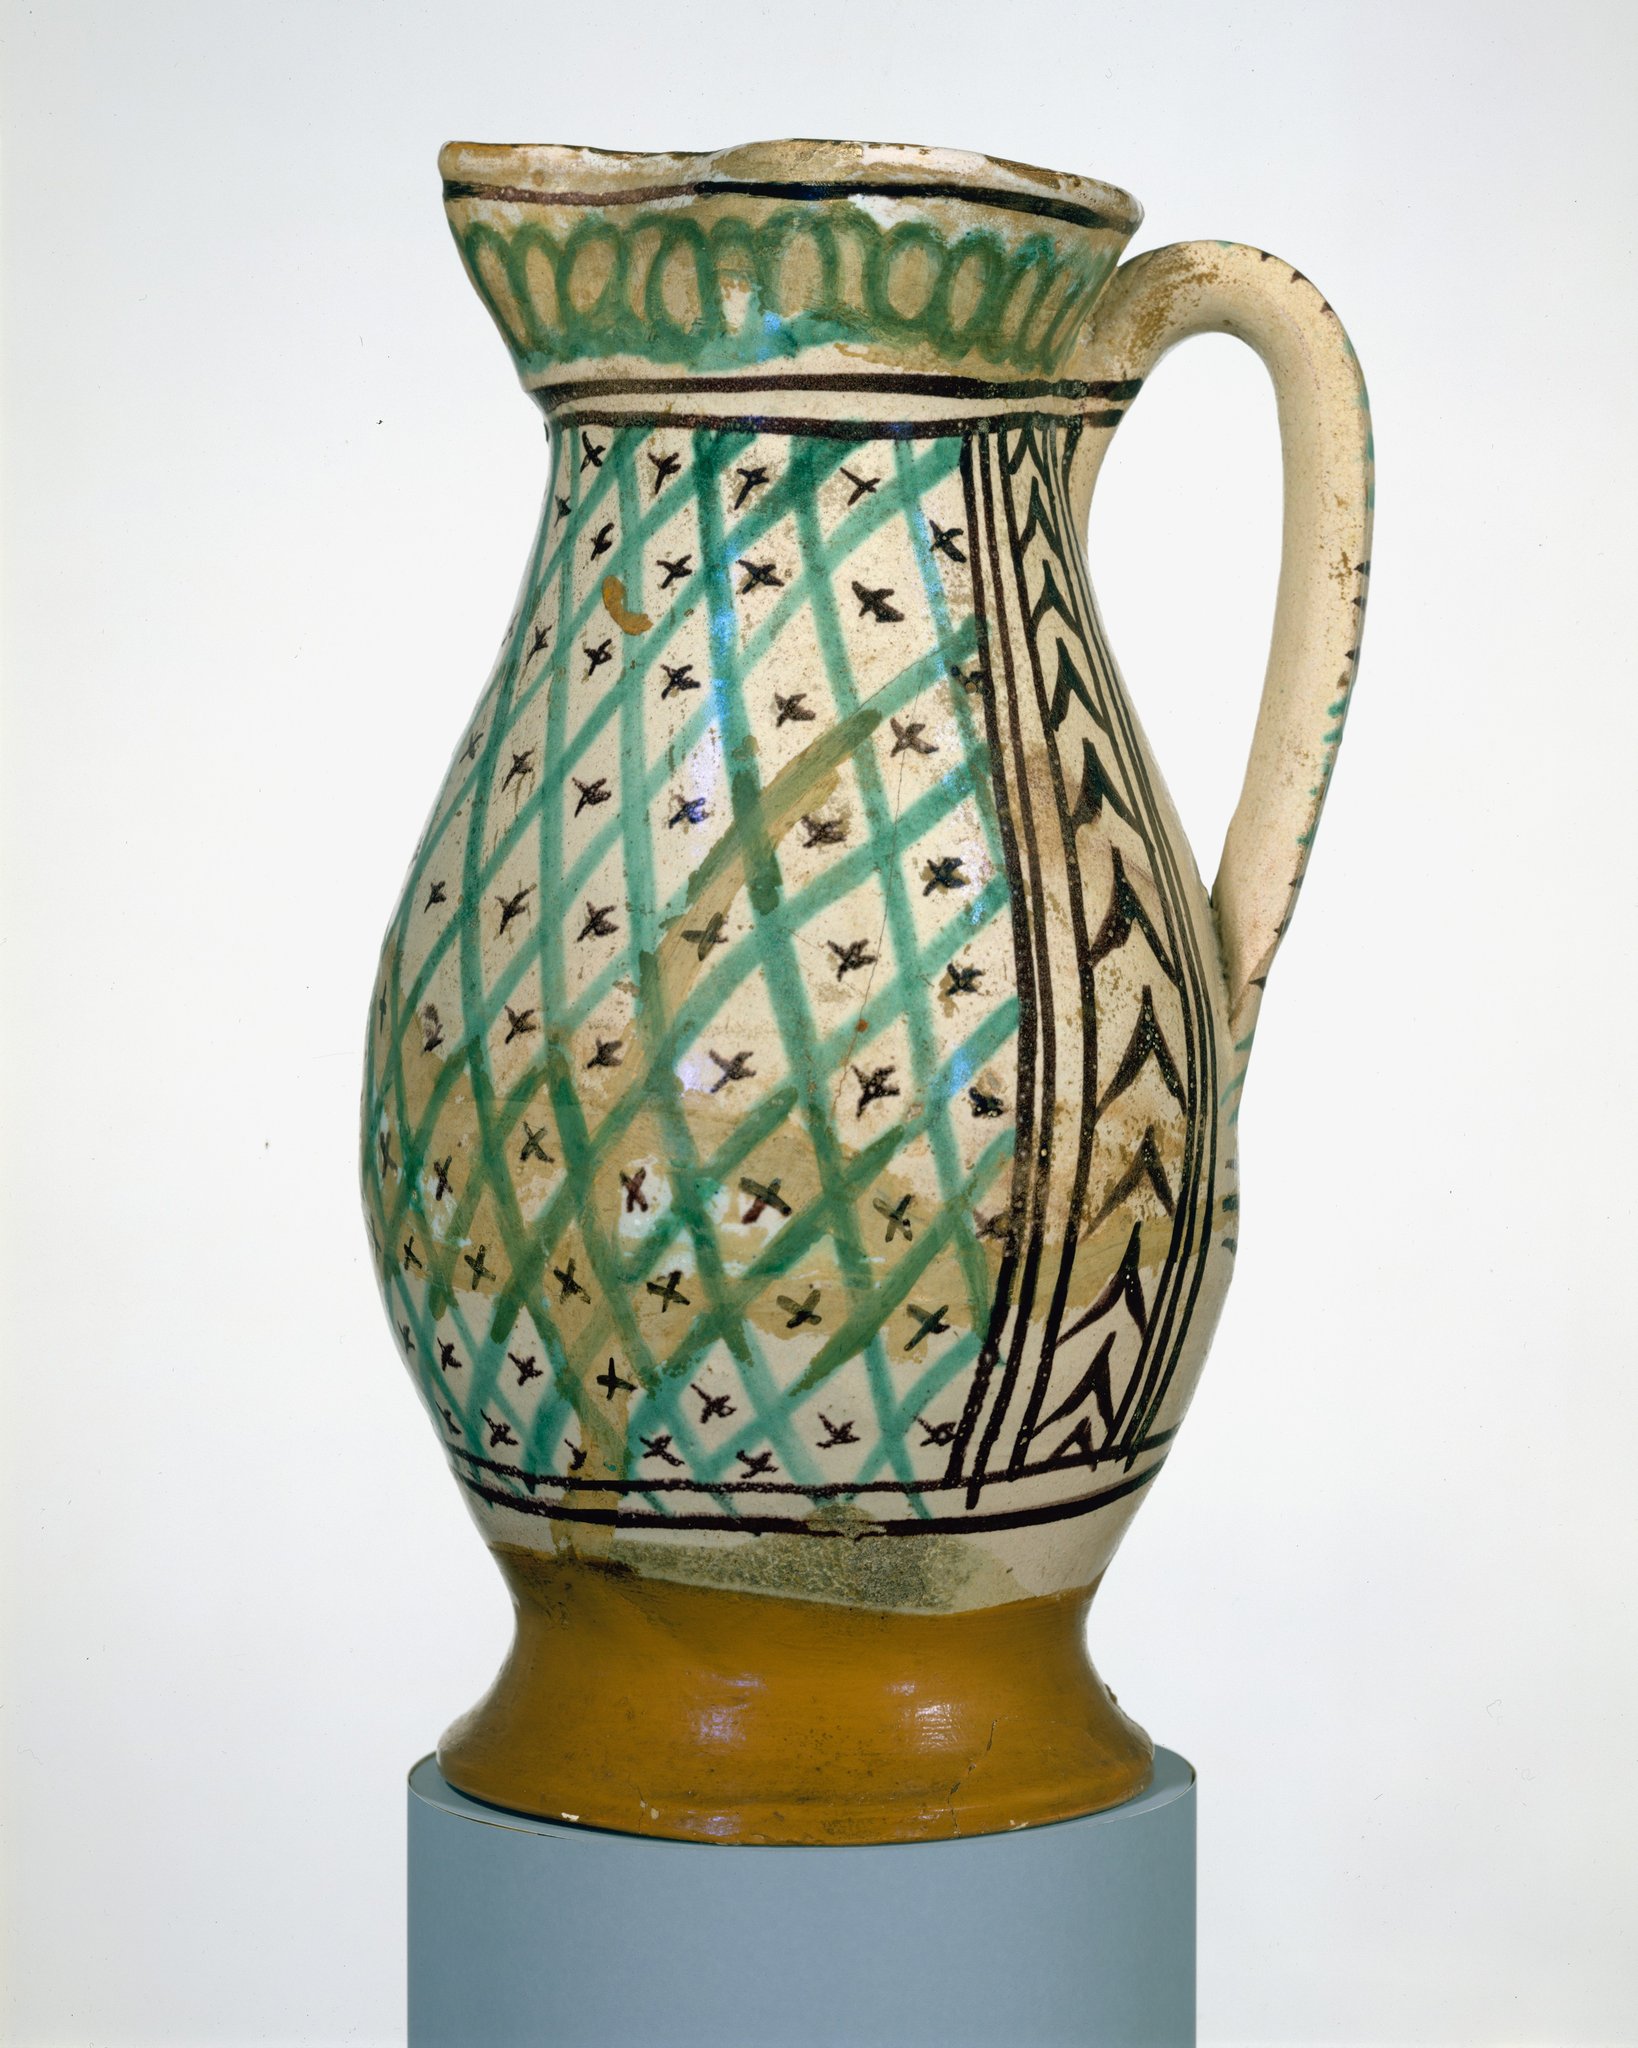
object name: jug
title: Jug (boccale)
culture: italian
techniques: maiolica, glazing